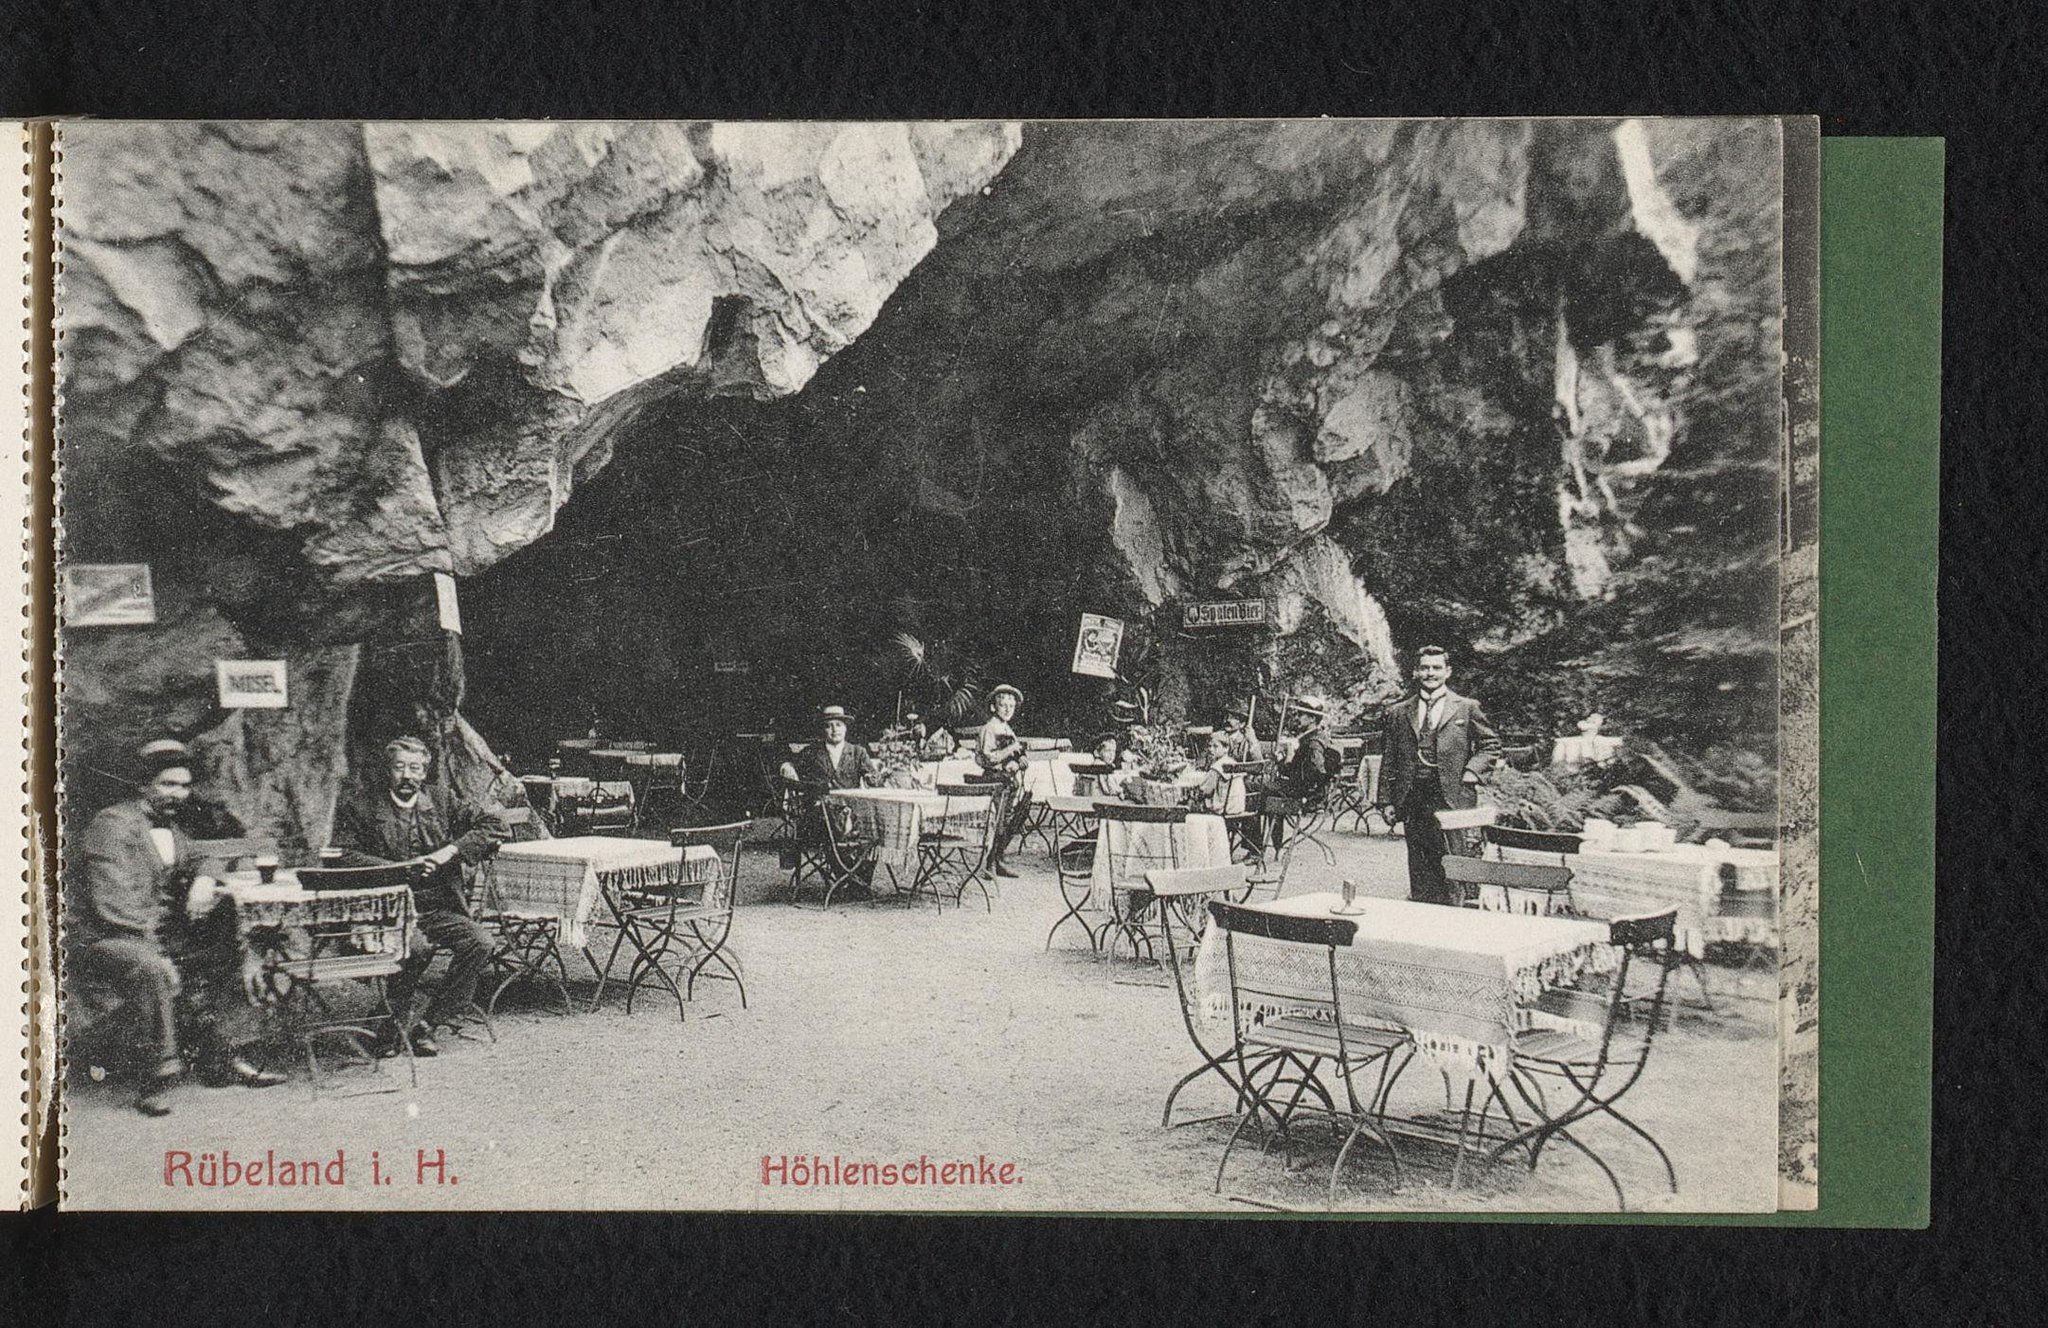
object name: photomechanical print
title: Rübeland i. H. Höhlenschenke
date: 1907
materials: cardboard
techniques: photograph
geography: halberstadt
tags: stalactitic cave, inn, coffee-house, public house, etc.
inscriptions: date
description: Prentbriefkaart maakt deel uit van een album.